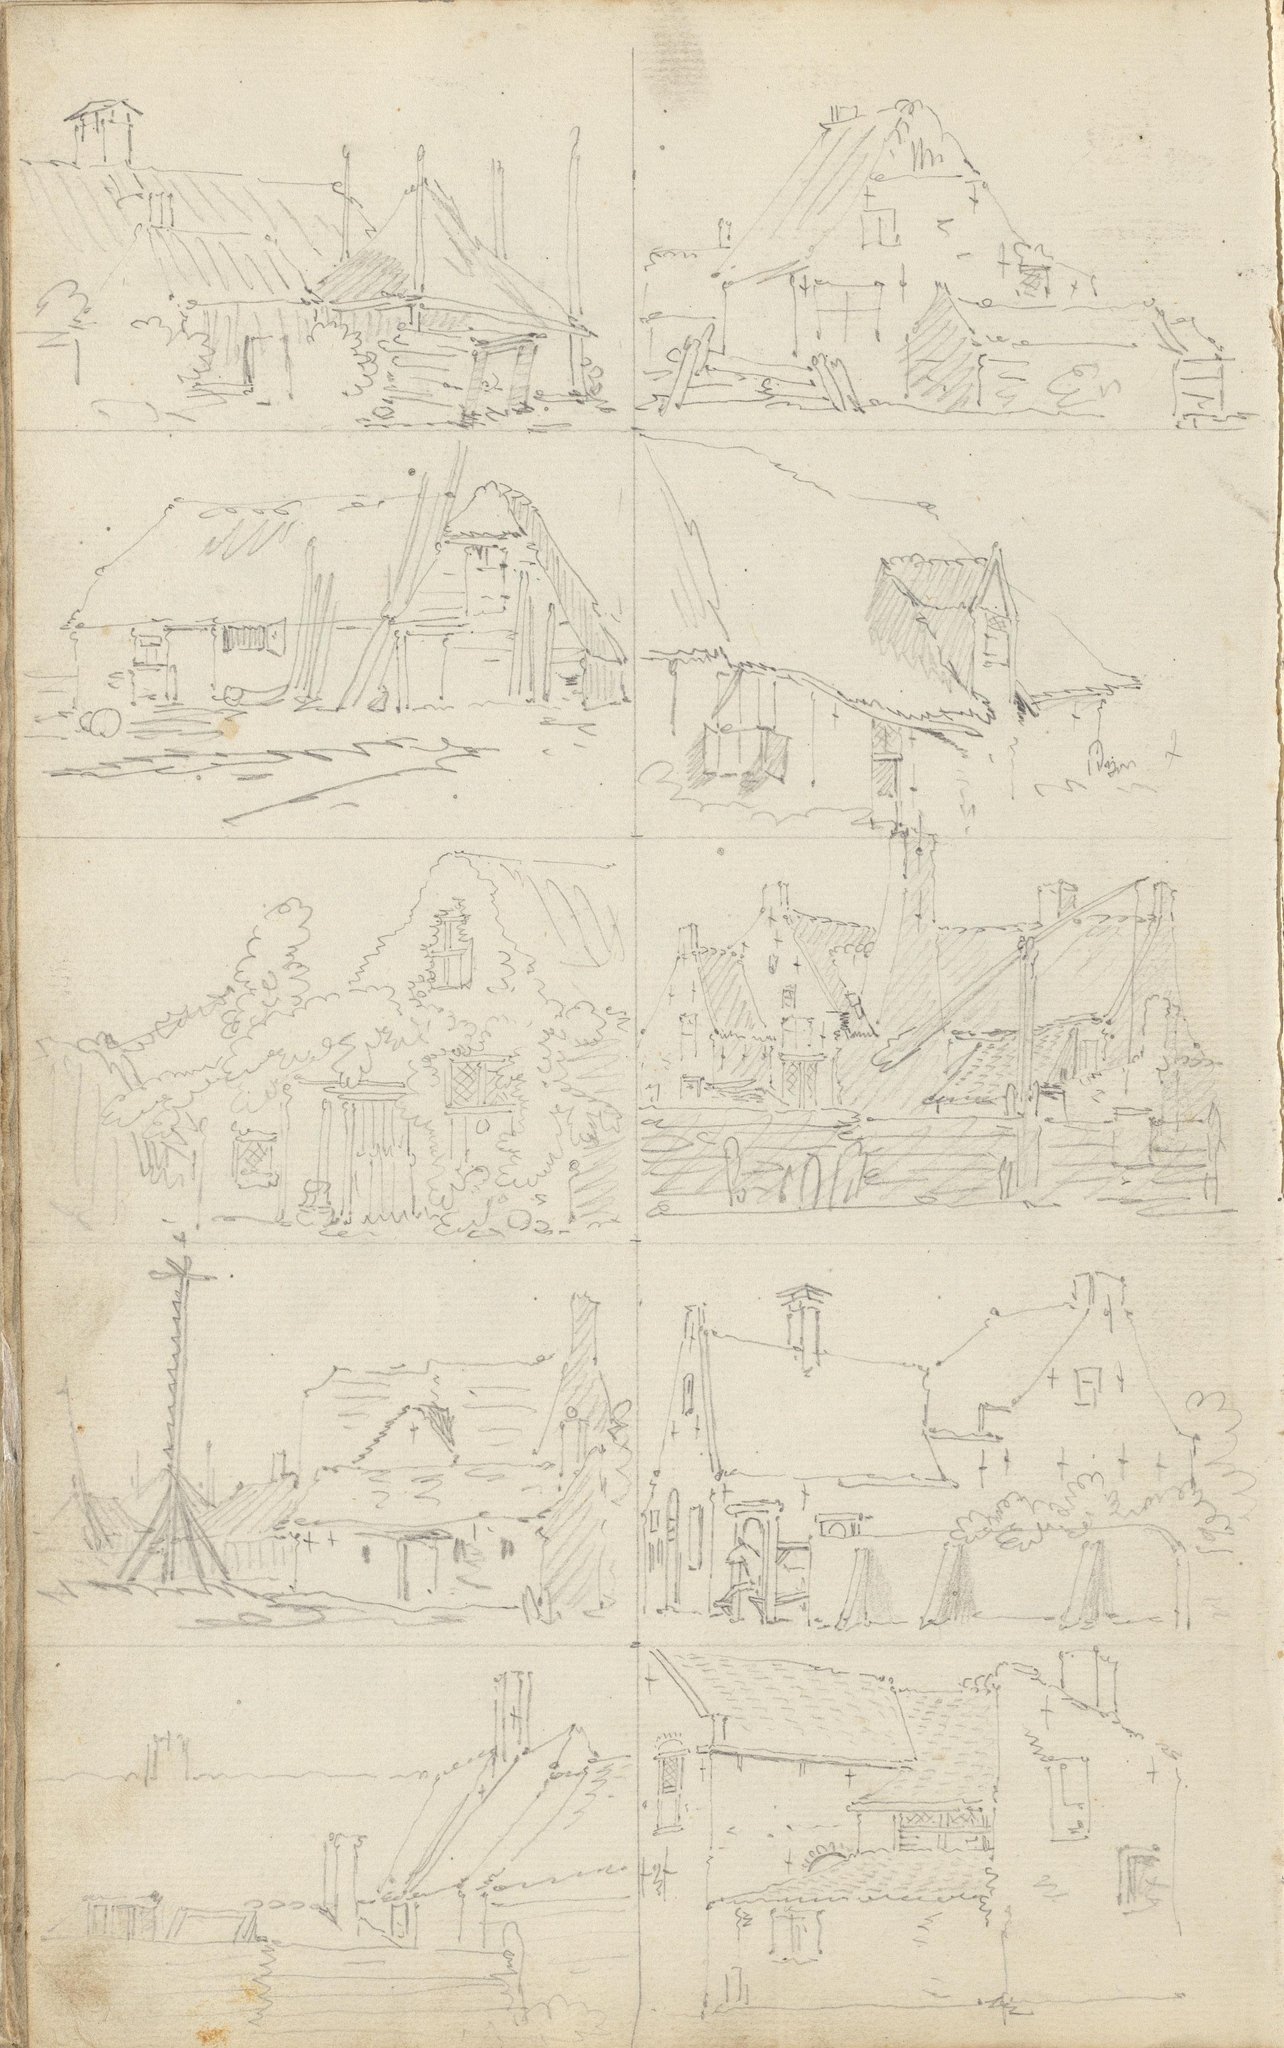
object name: sketchbook leaf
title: Boerderijen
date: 1780-1800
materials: paper, pencil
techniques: drawing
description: Blad 13 verso uit een schetsboek met 17 bladen.